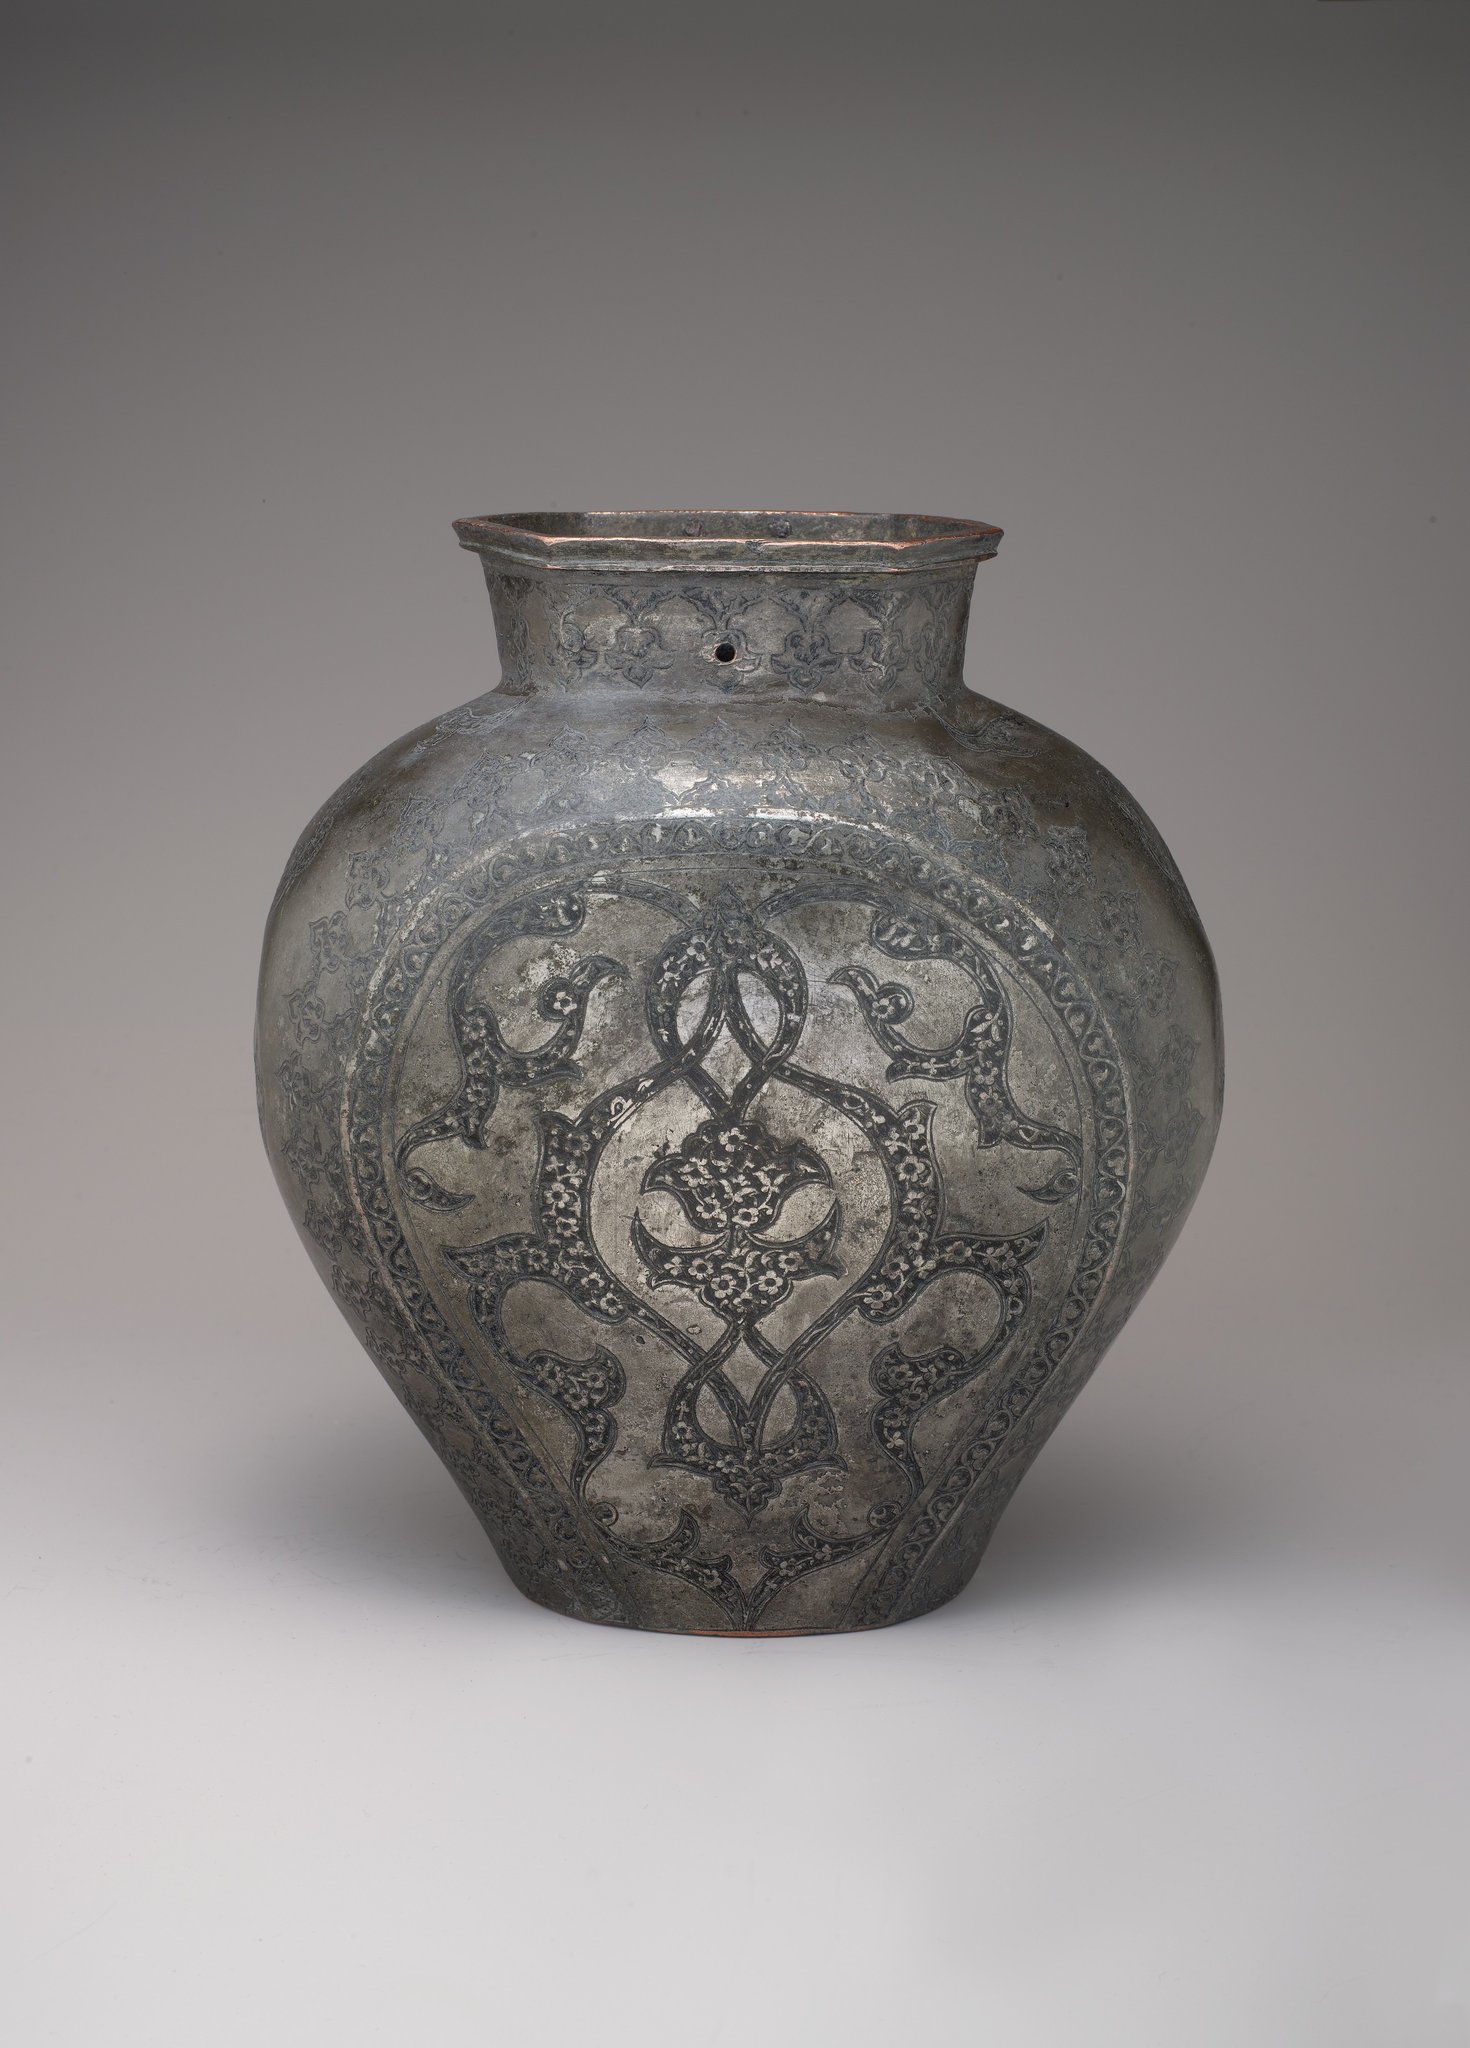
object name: vase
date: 1601-1800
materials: copper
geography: iran